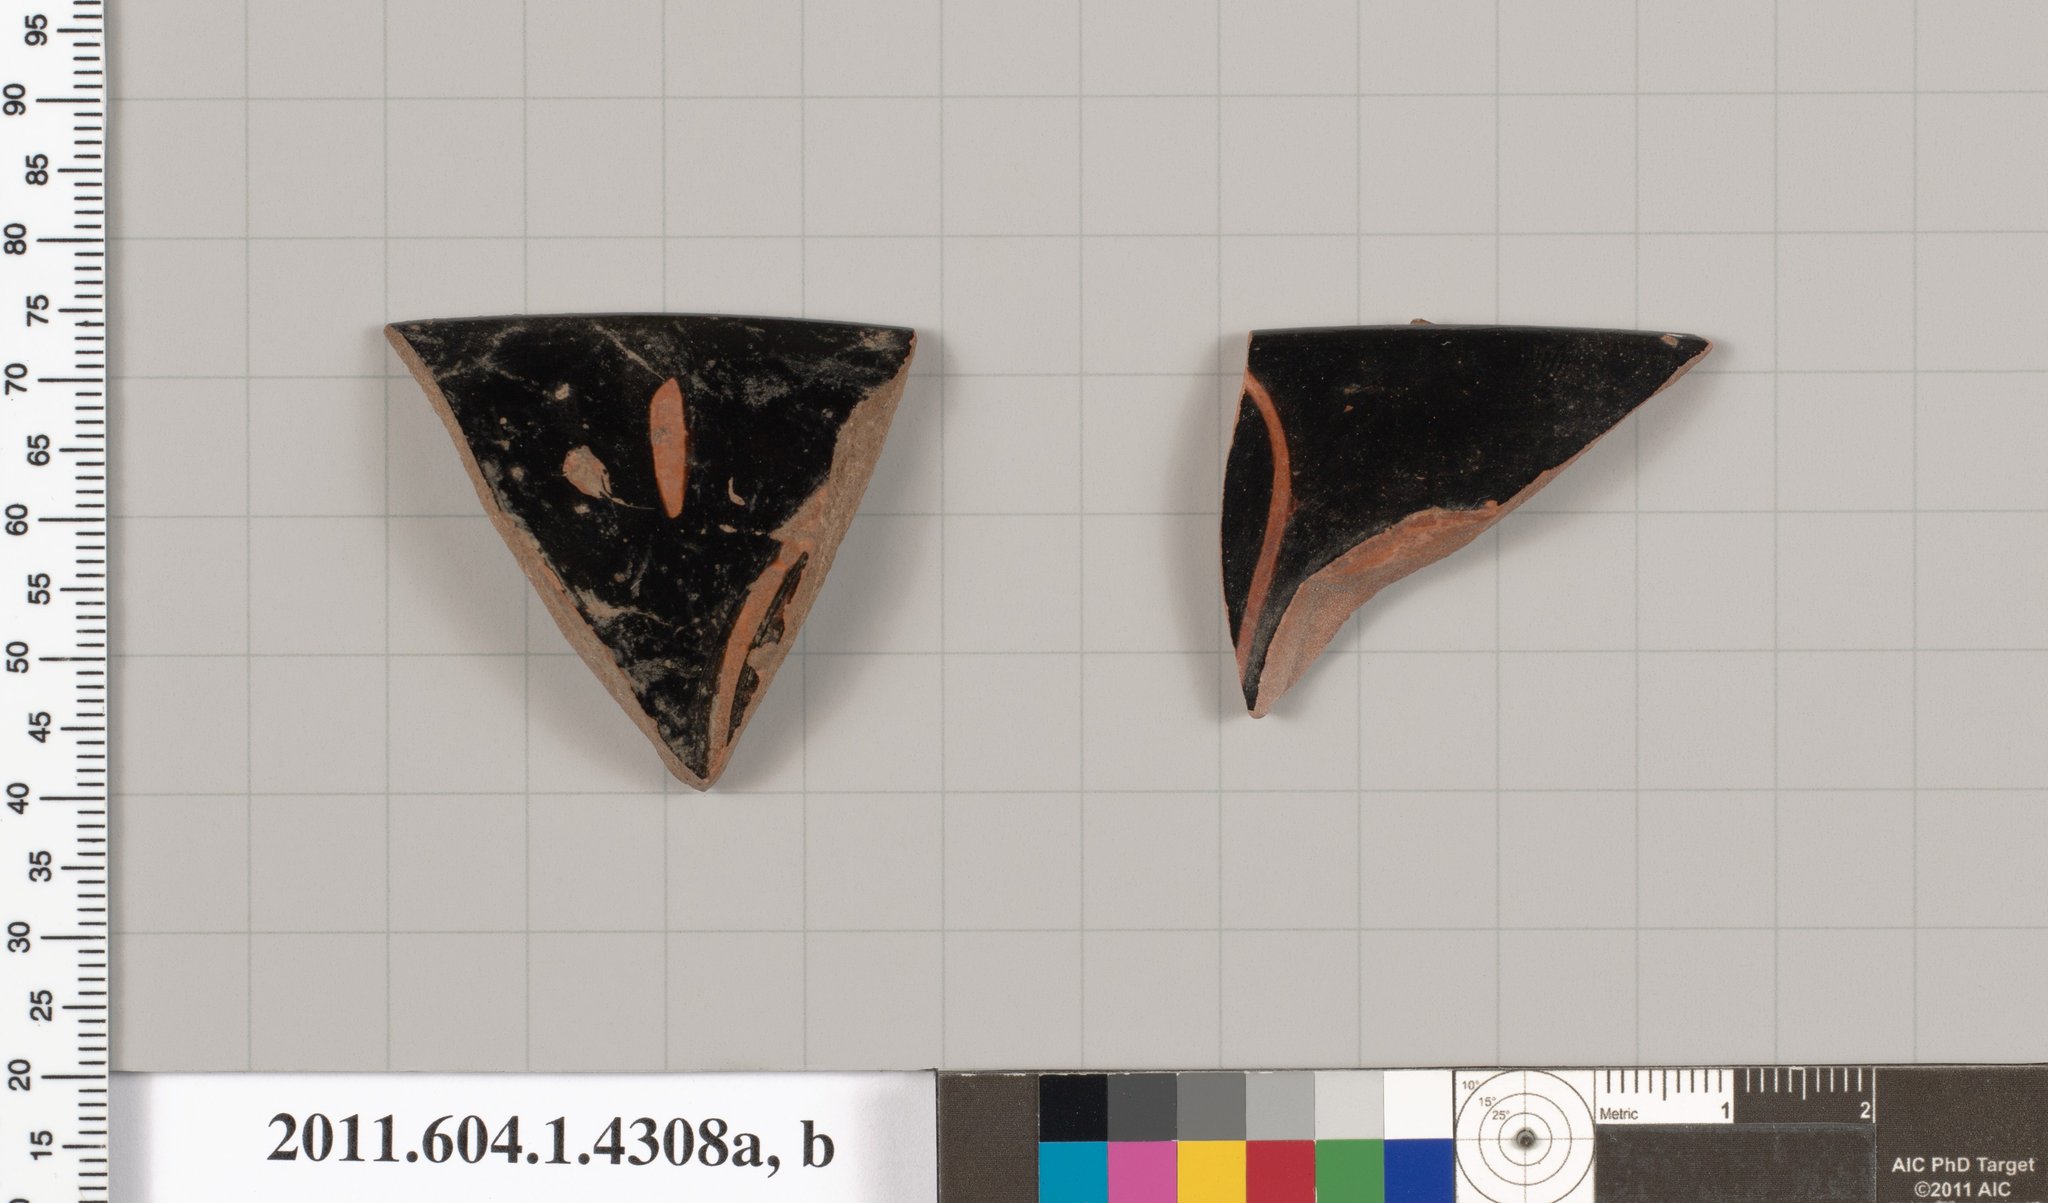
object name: kylix fragment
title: Terracotta rim fragments of kylikes (drinking cups)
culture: greek, attic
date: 500-451 BCE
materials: terracotta